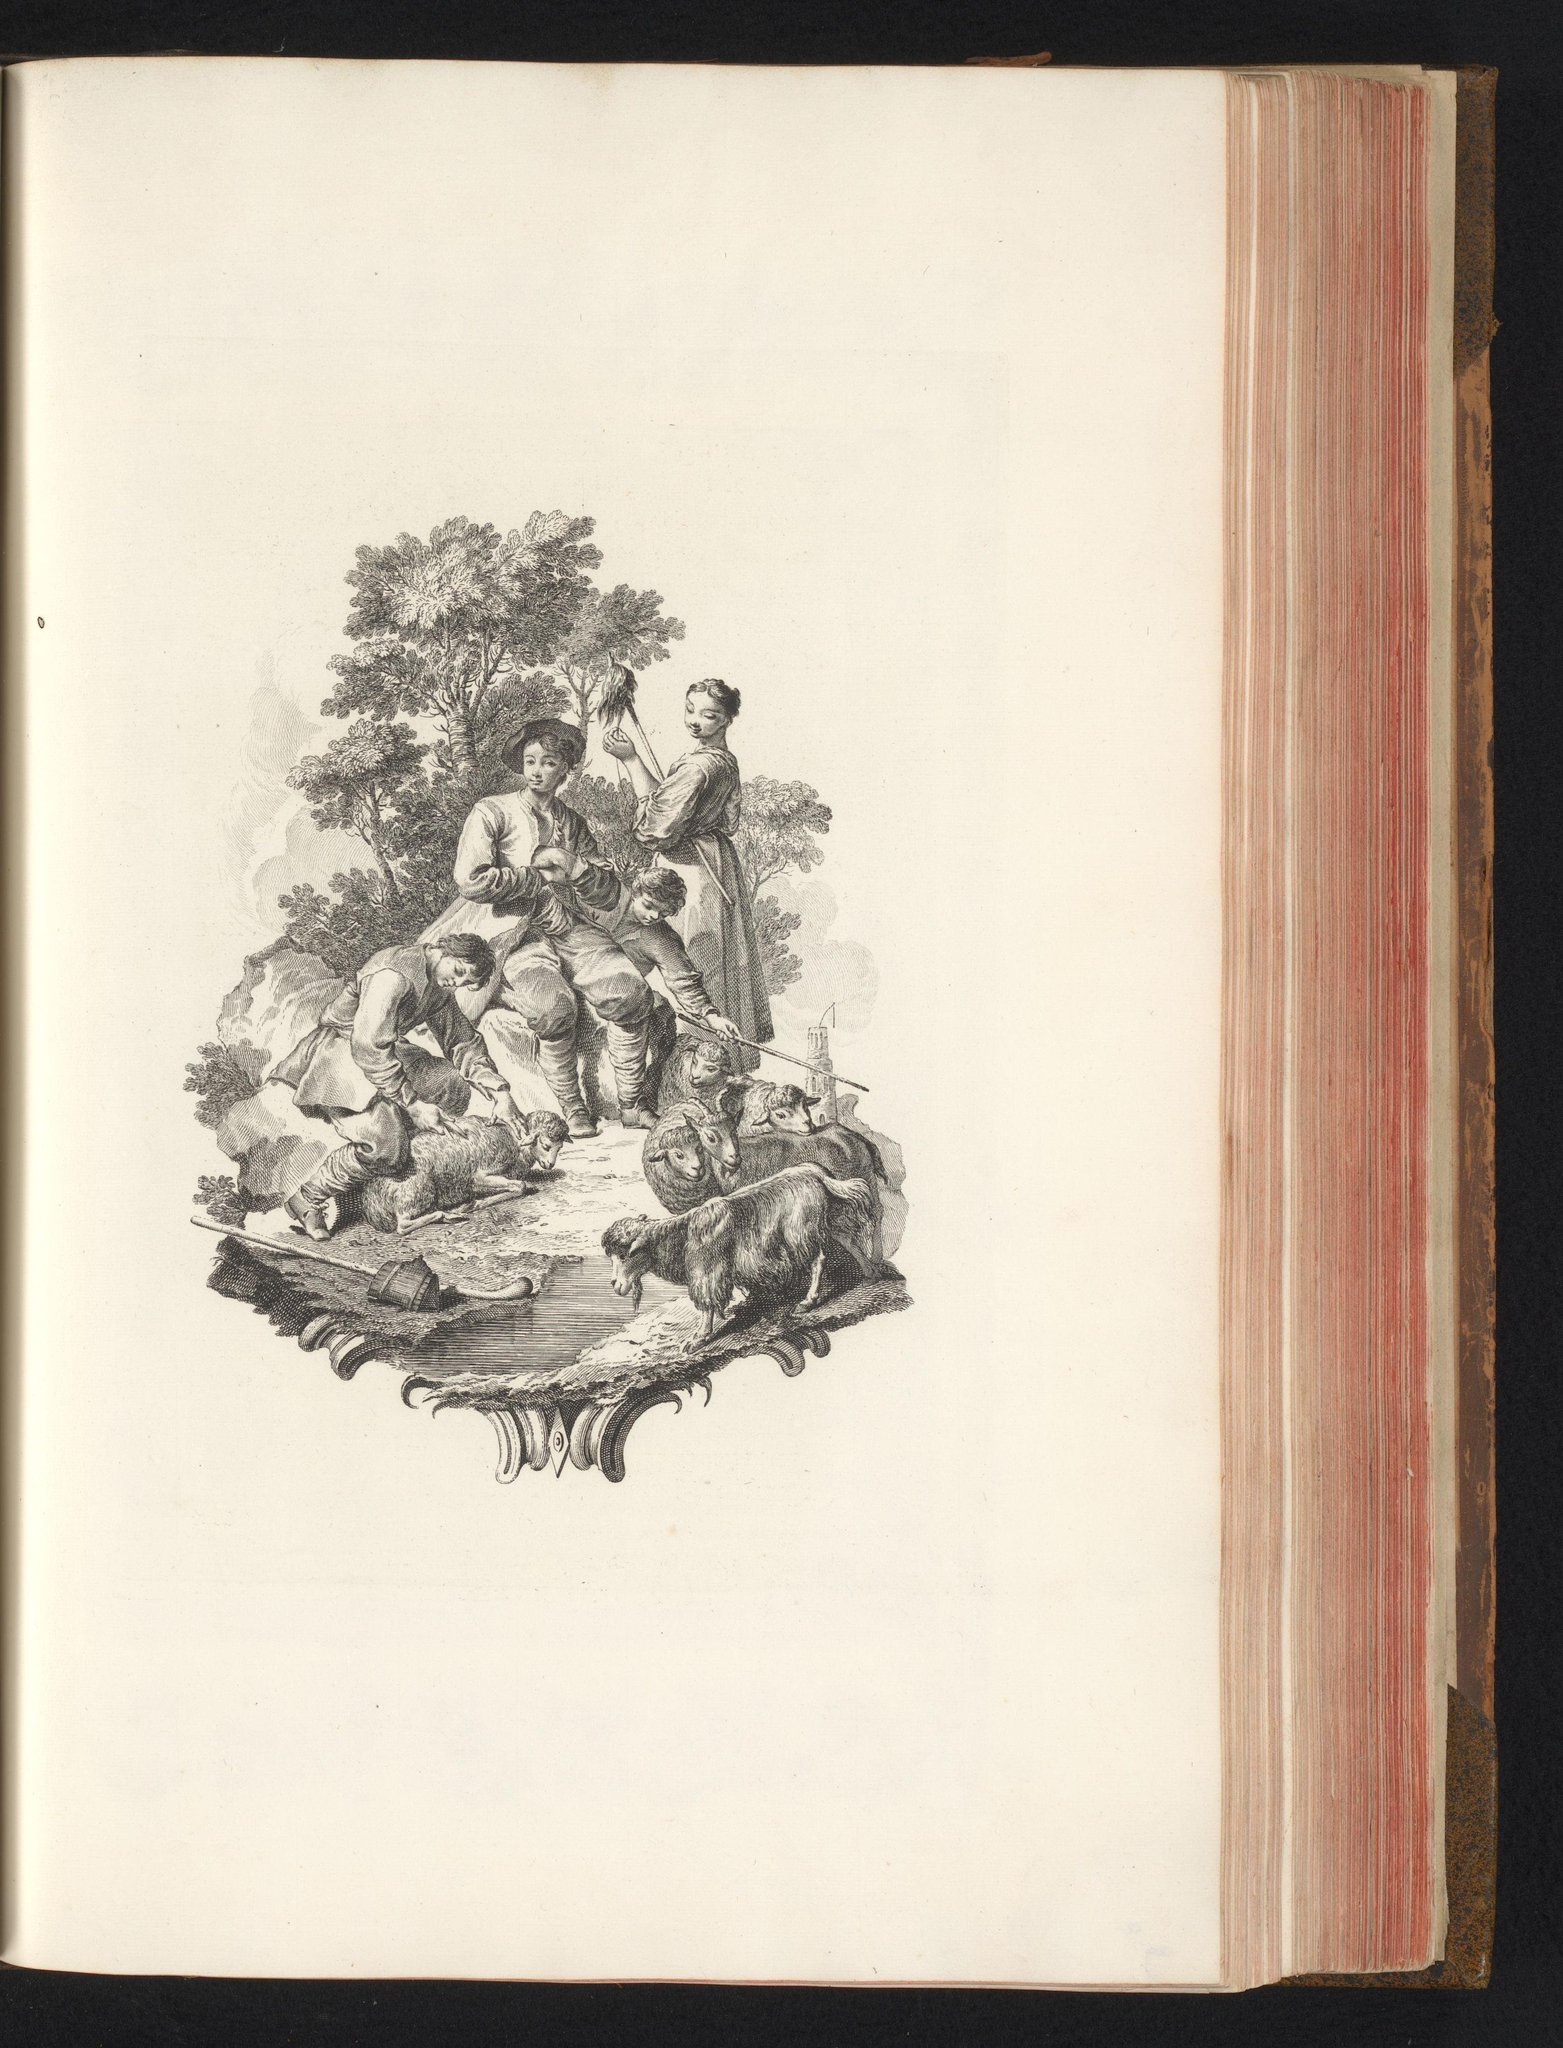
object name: page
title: Herders scheren een schaap terwijl een vrouw wol spint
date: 1745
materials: paper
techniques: etching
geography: venice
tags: herding, herdsman, herdswoman, shepherd, shepherdess, cowherd, etc., distaff, (scenes from) specific works of literature: tasso, gerusalemme liberata, shearing (sheep)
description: Prent uit: Tasso, Torquato. La Gerusalemme liberata di Torquato Tasso con le figure de Giambatista Piazzetta. Venetië: Giambatista Albrizzi, 1745.